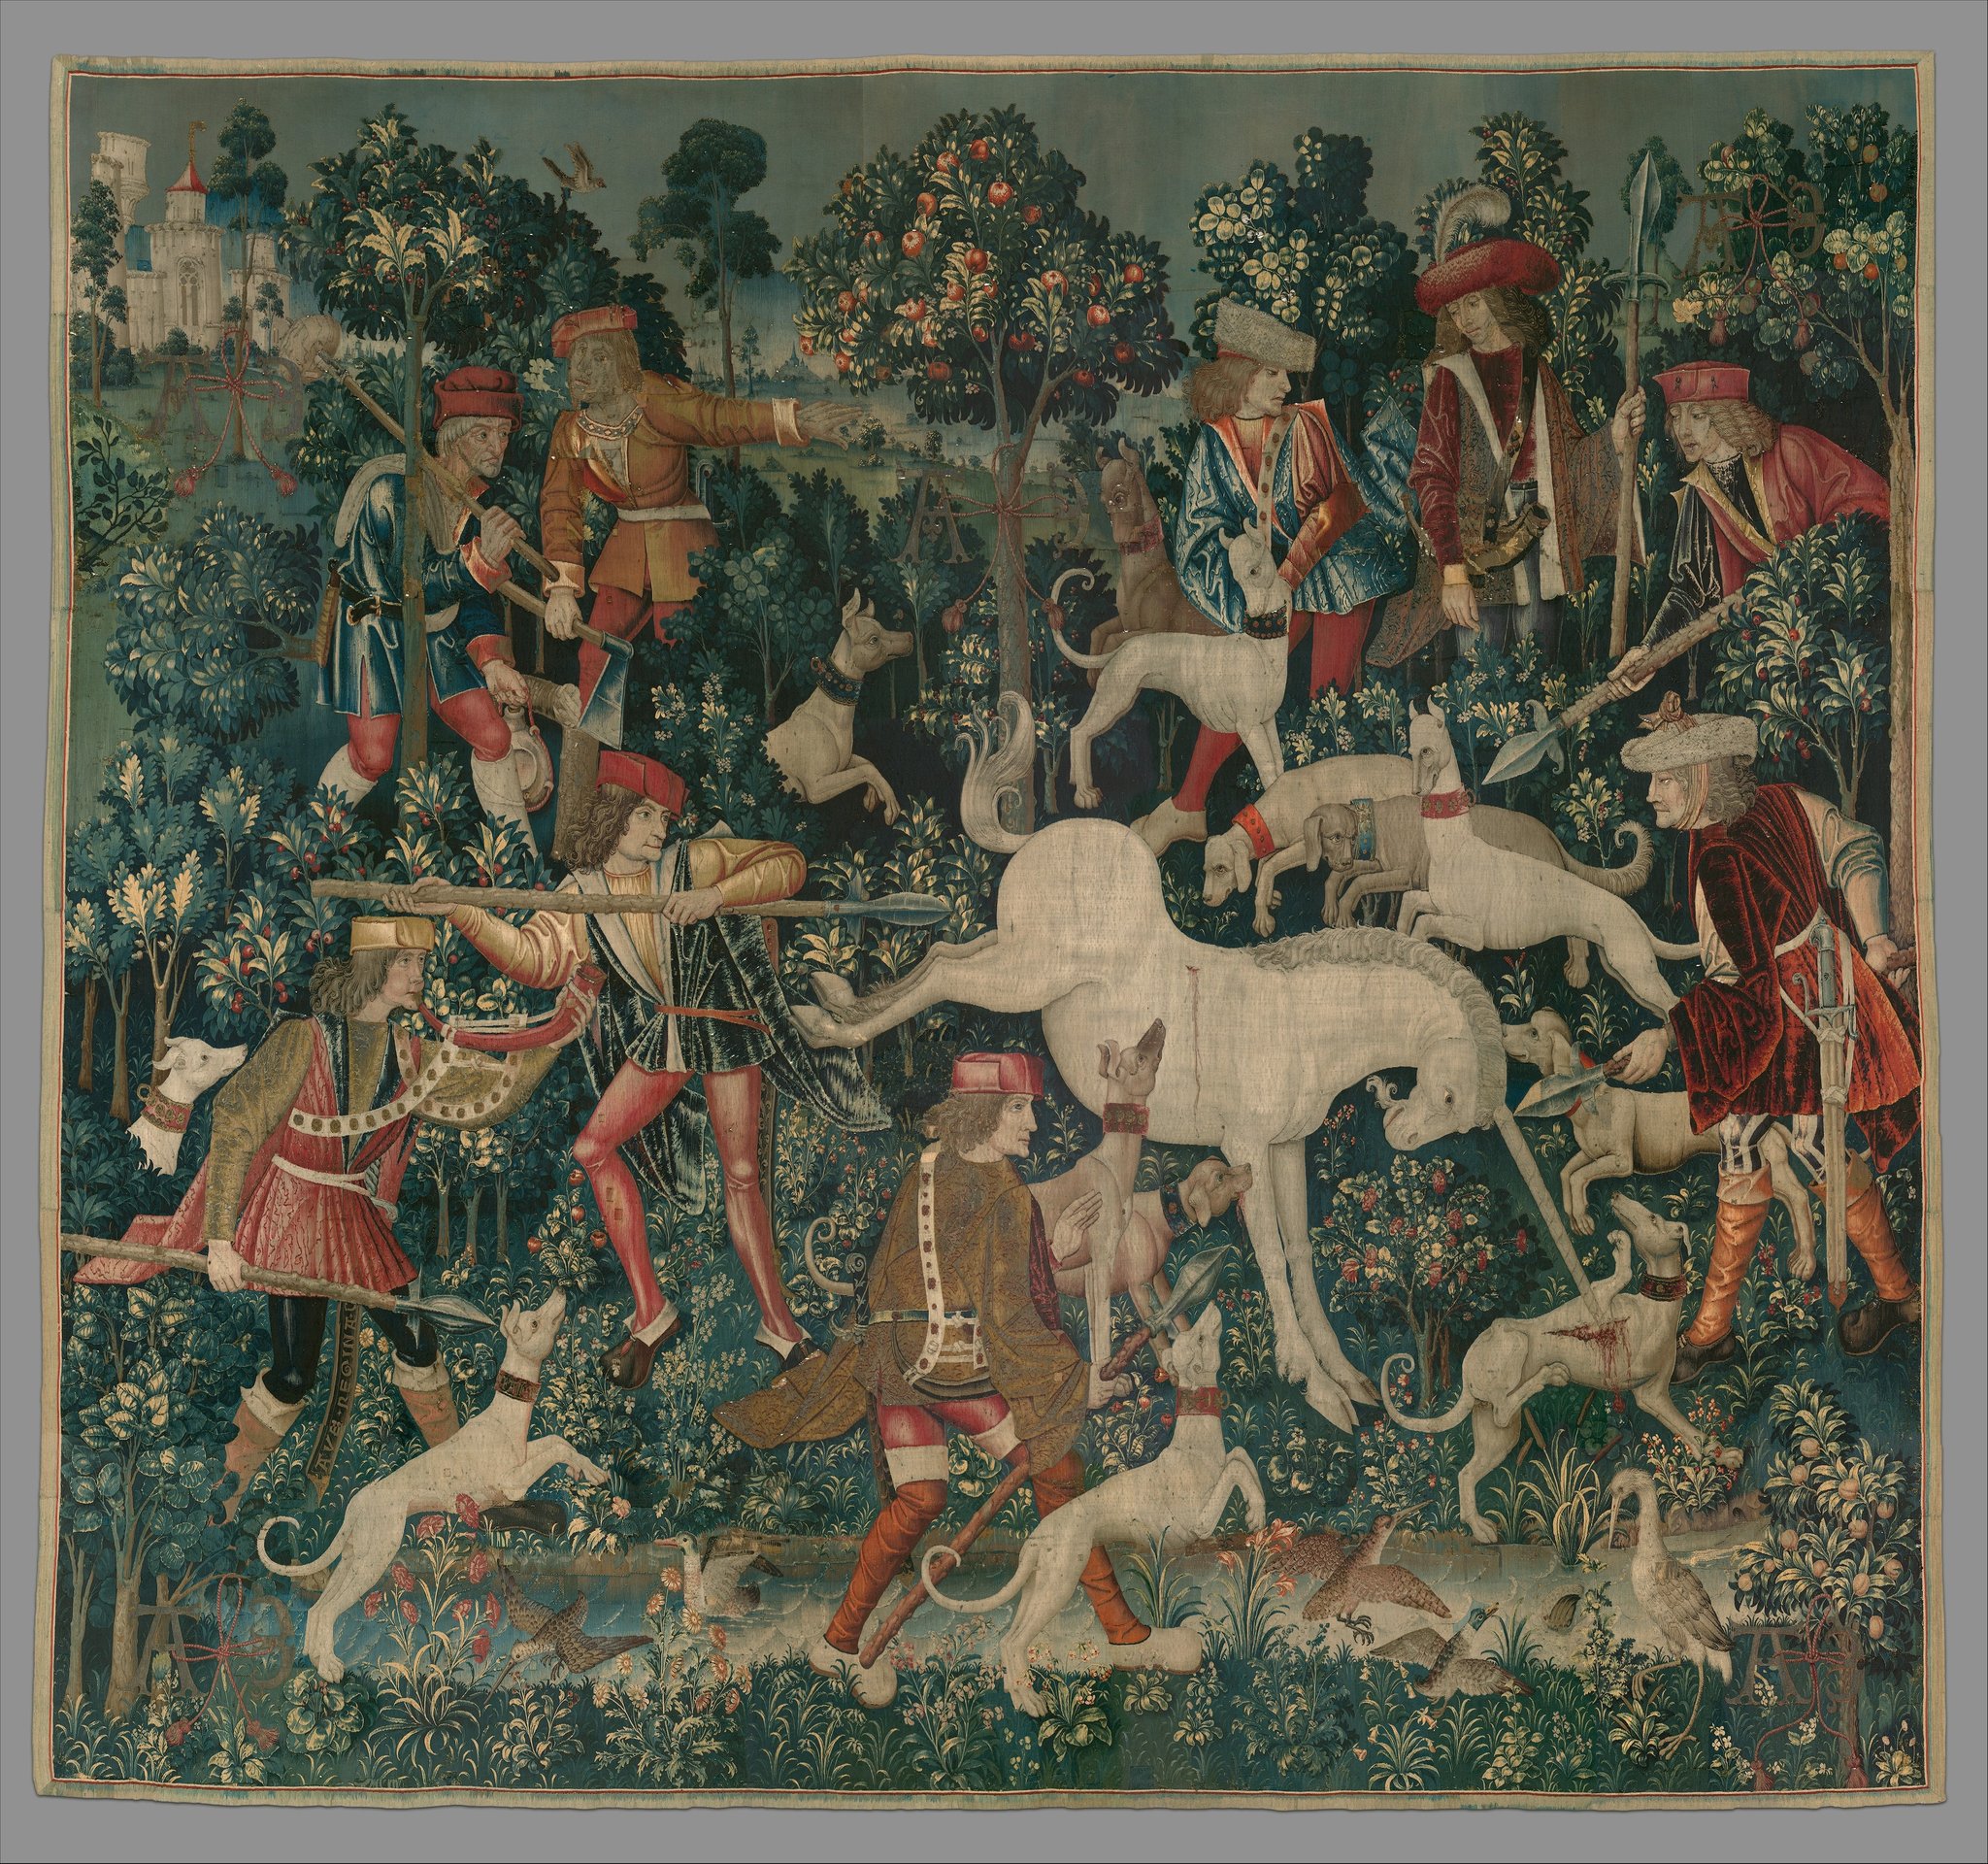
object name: tapestry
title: The Unicorn Defends Himself (from the Unicorn Tapestries)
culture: french or south netherlandish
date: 1495-1505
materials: gilt, silk, silver, wool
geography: netherlands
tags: birds,castles,spears,men,hunting,horns,unicorns,dogs,forests,trees,streams